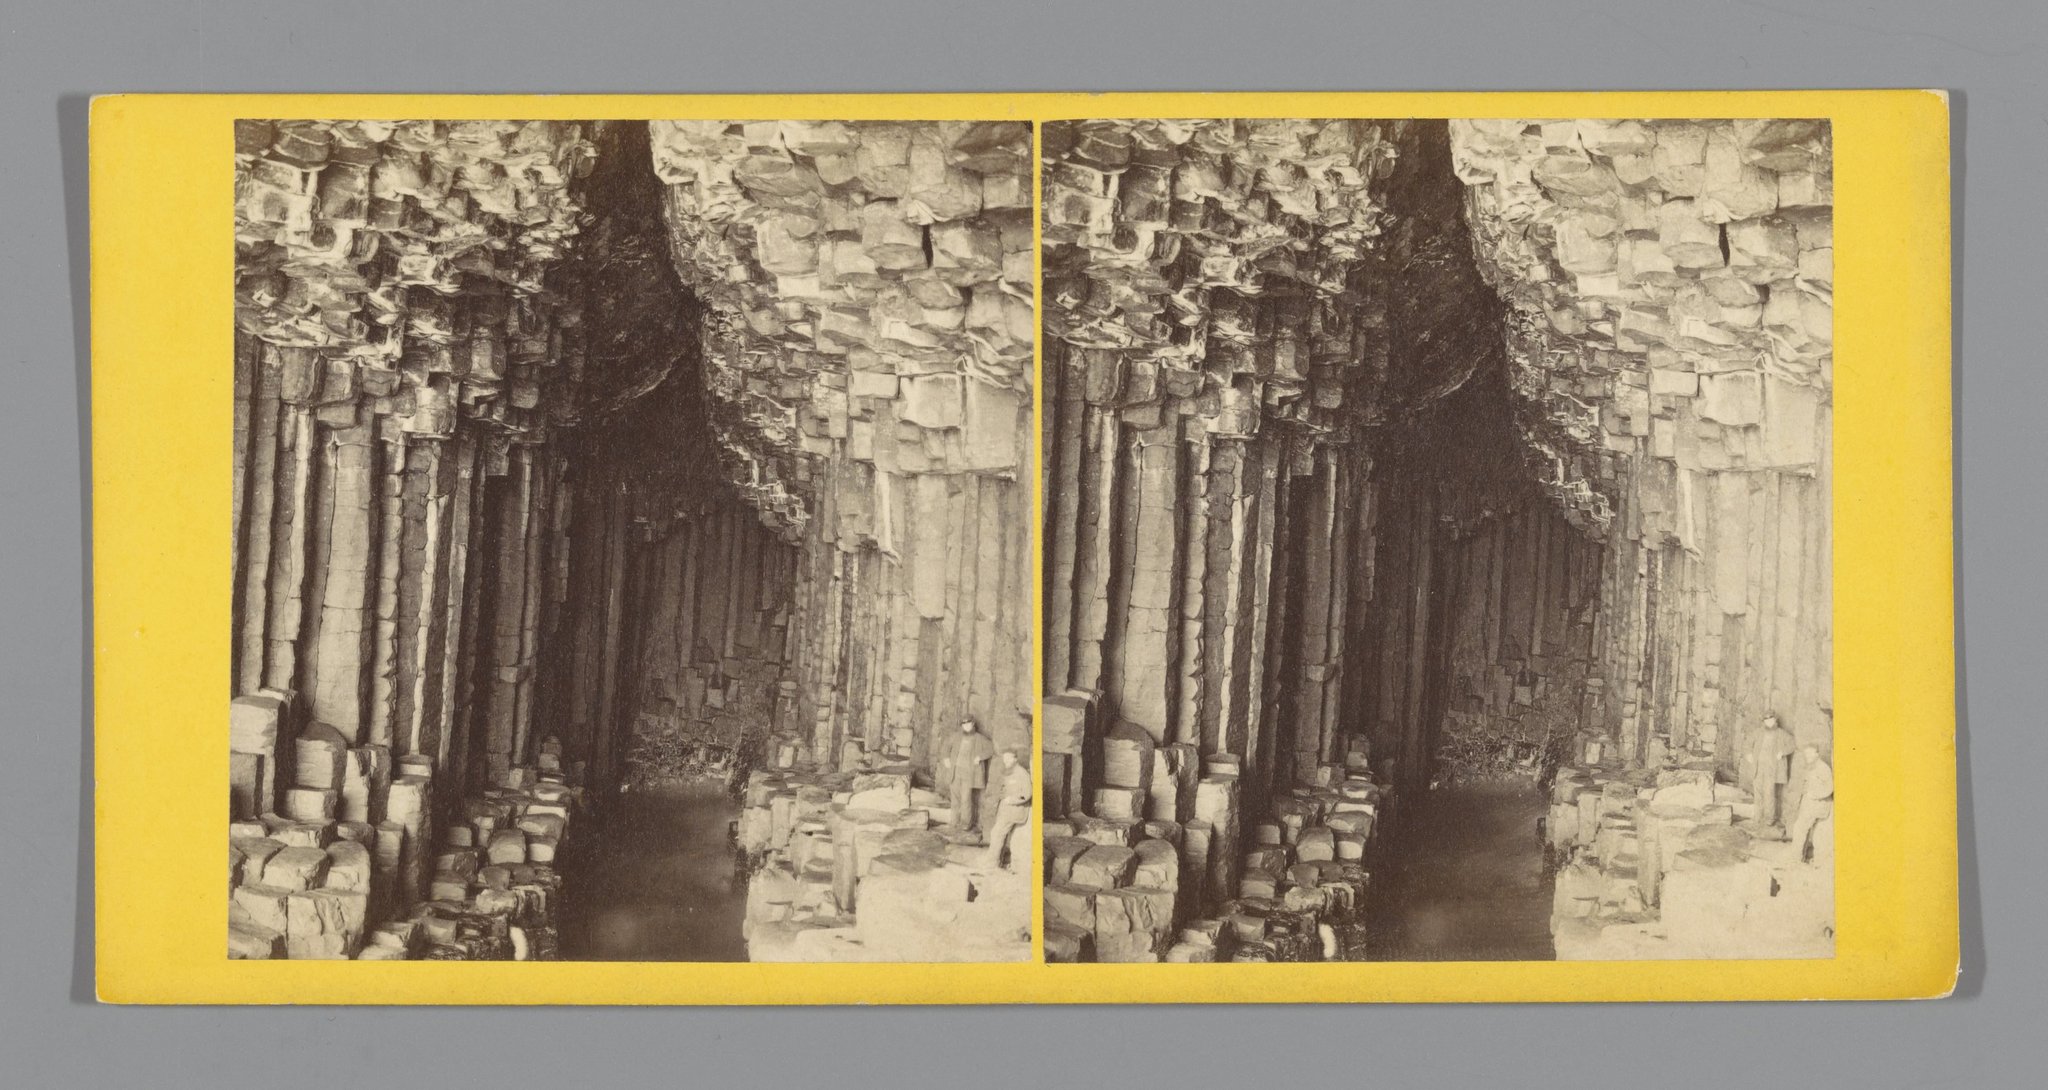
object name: stereograph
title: Fingal's Cave, Staffa, looking in.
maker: george washington wilson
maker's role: publisher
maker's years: 1823-1893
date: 1850-1880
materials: cardboard, photographic support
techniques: albumen print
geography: staffa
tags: cave, grotto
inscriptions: number: ‘No. 145 A.’, name: ‘Registered G. W. Wilson Photographer, Aberdeen’